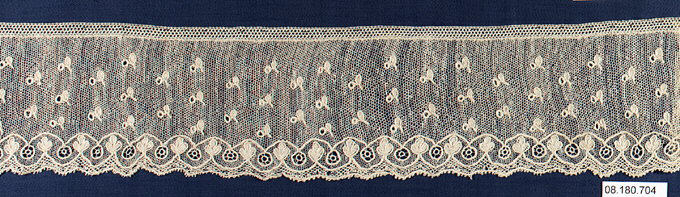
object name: fragment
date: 1701-1800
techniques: lace